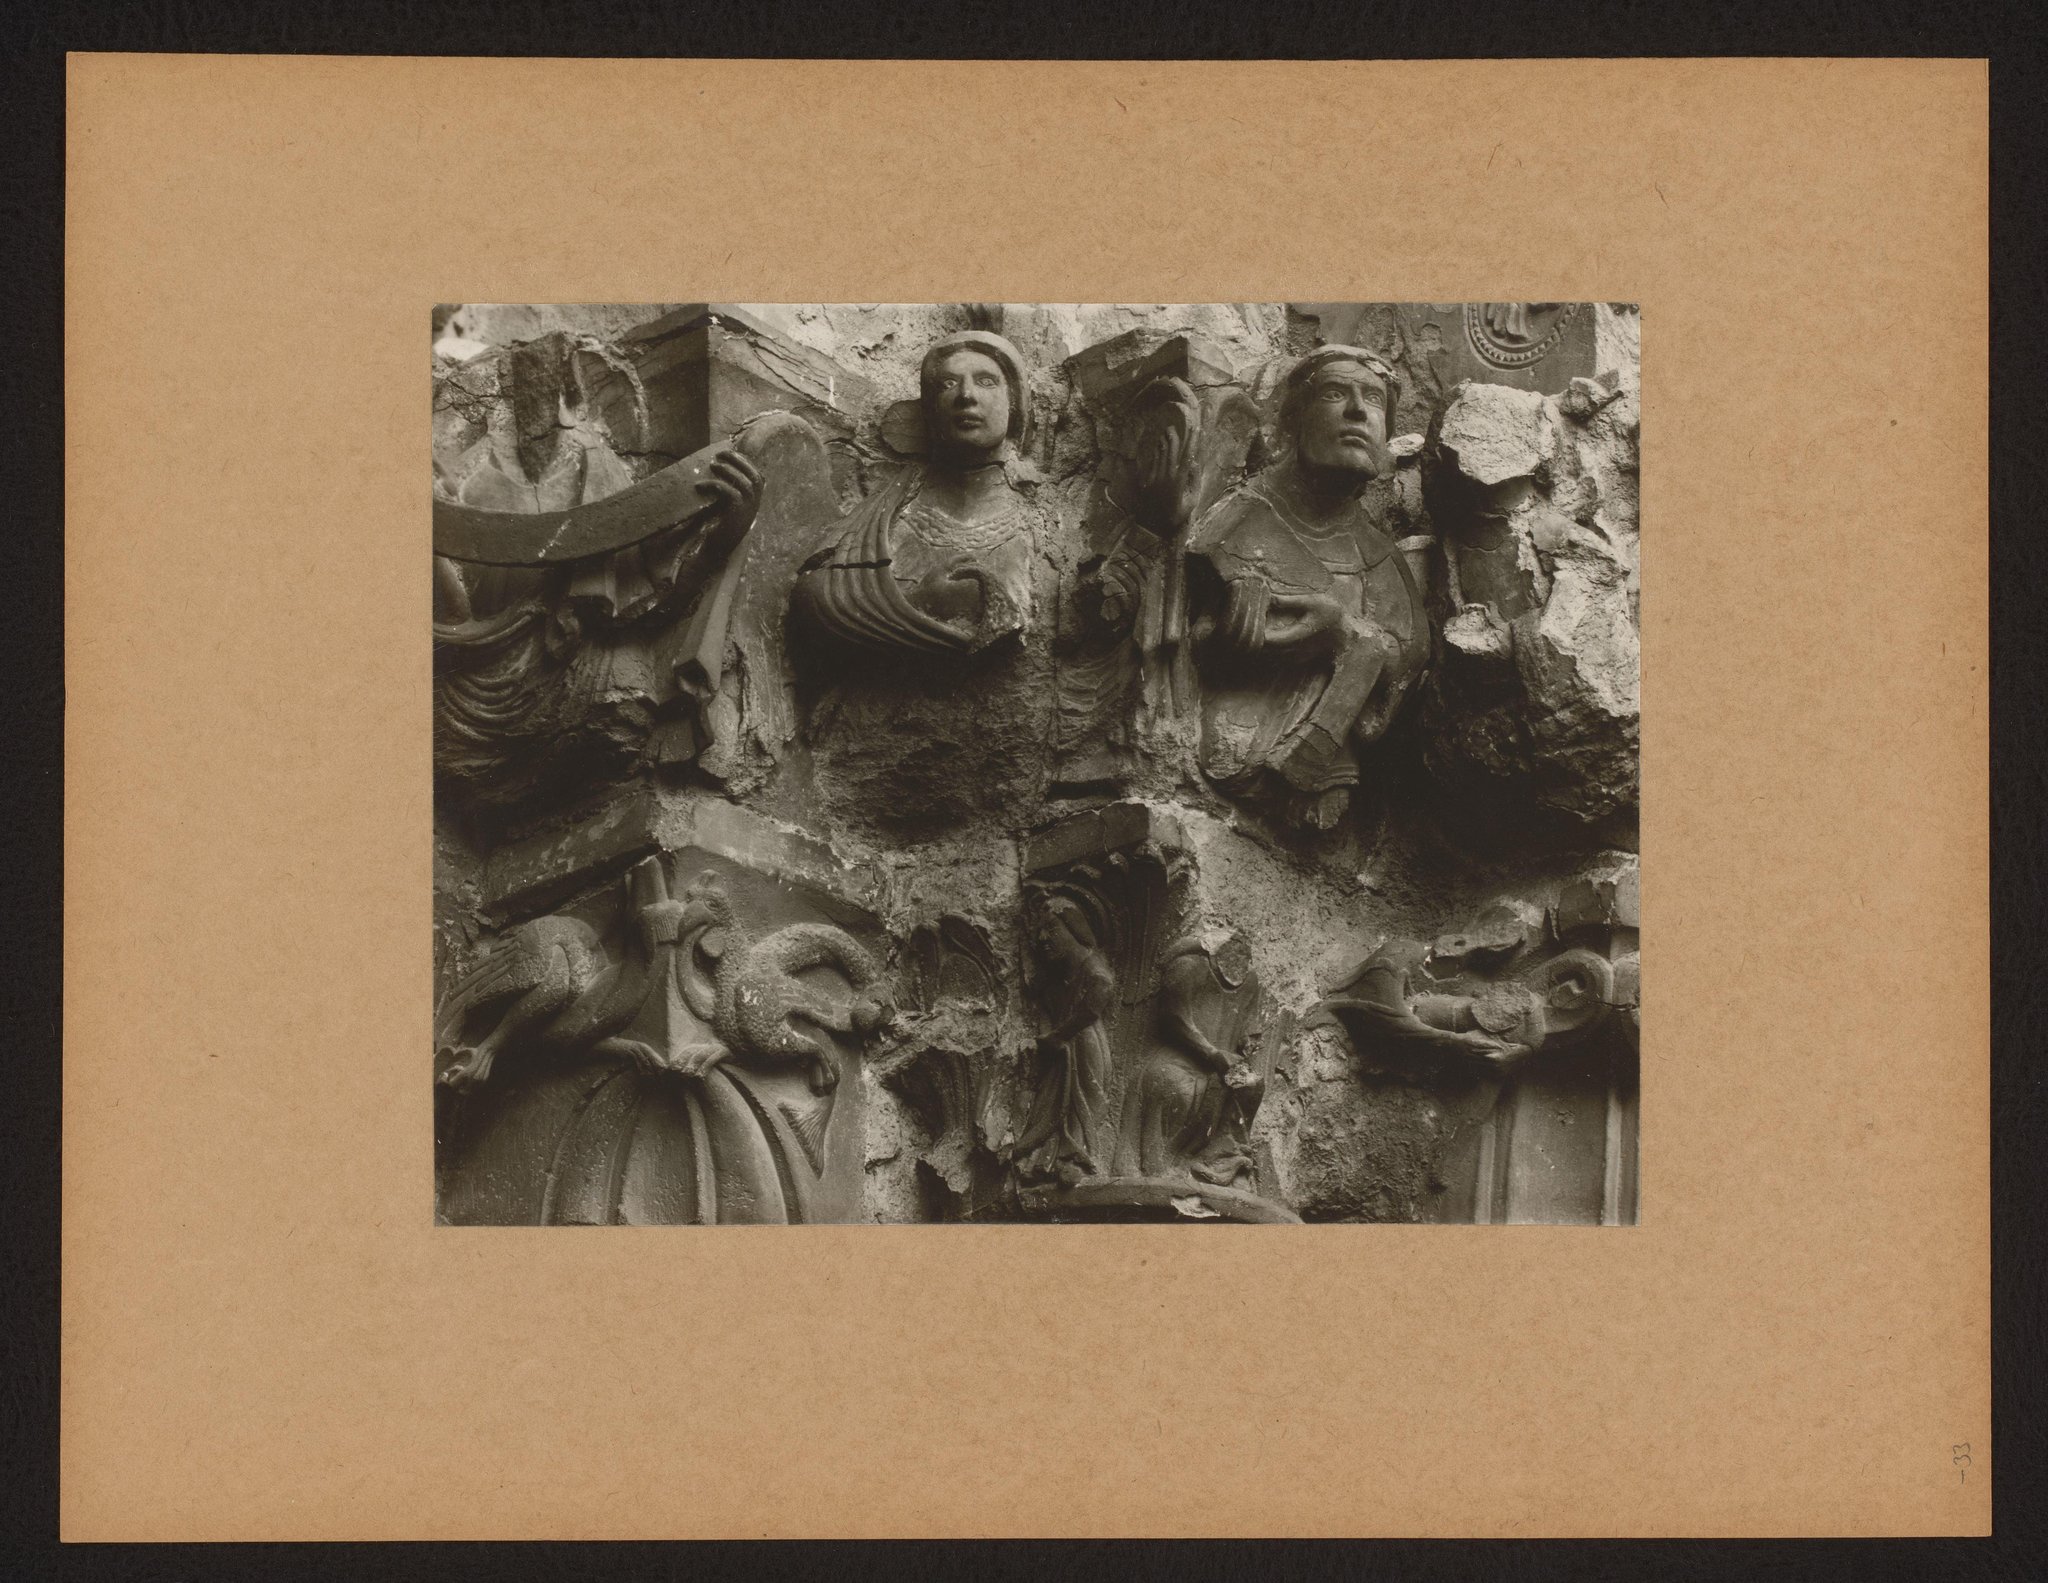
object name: photograph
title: Detail van een kapiteel van de Gnadenpforte in de dom van Bamberg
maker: Anonymous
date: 1900-1920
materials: paper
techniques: gelatin silver print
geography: bamberg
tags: church (exterior)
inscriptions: number: ‘33.’